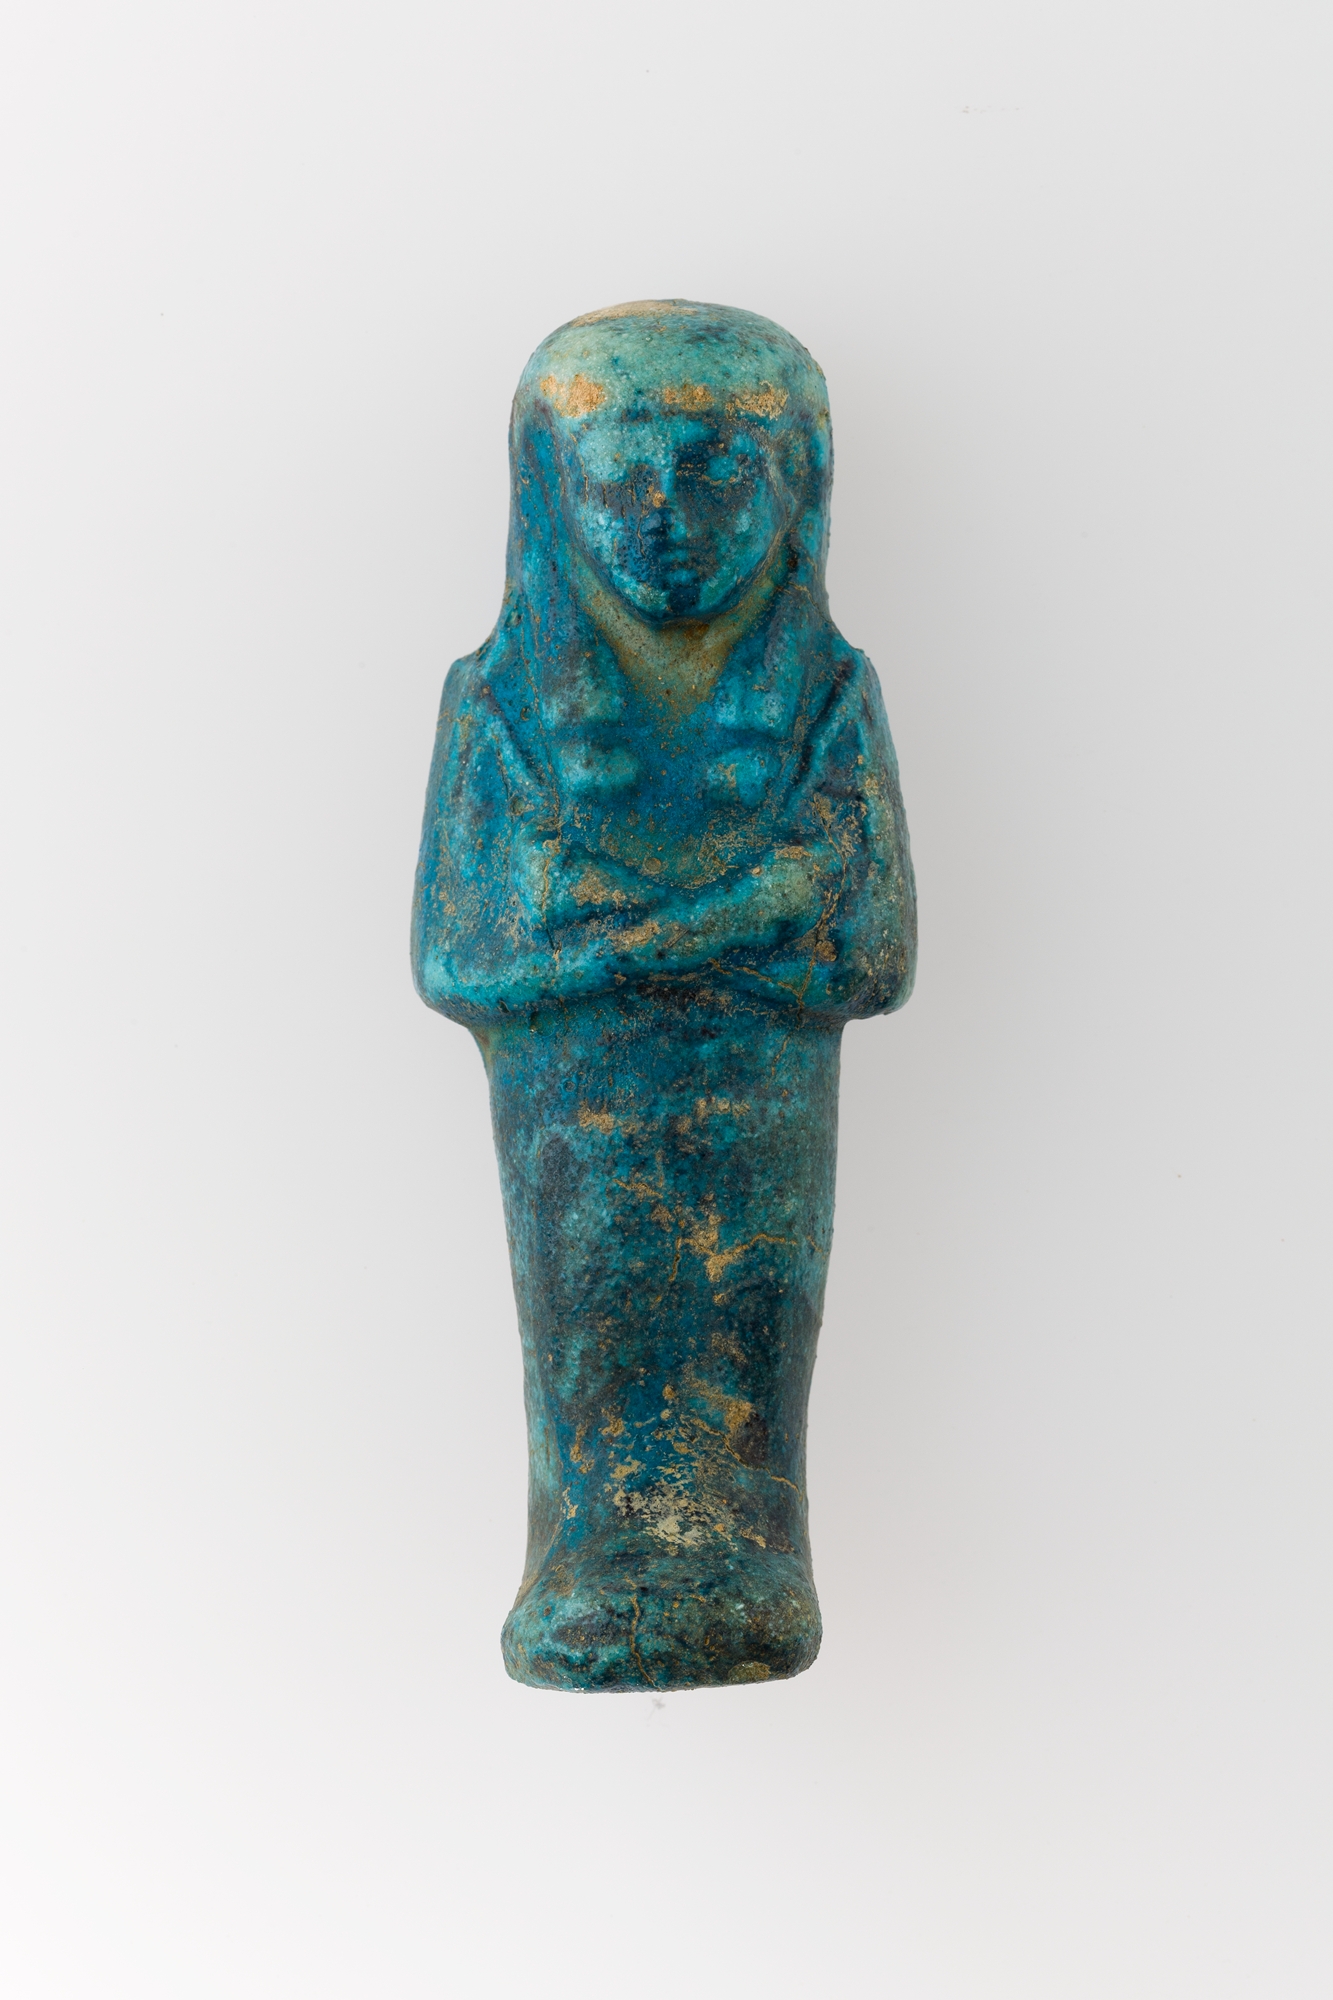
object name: shabti, henettawy c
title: Worker Shabti of Henettawy (C), Daughter of Isetemkheb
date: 990-970 BCE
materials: faience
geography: egypt